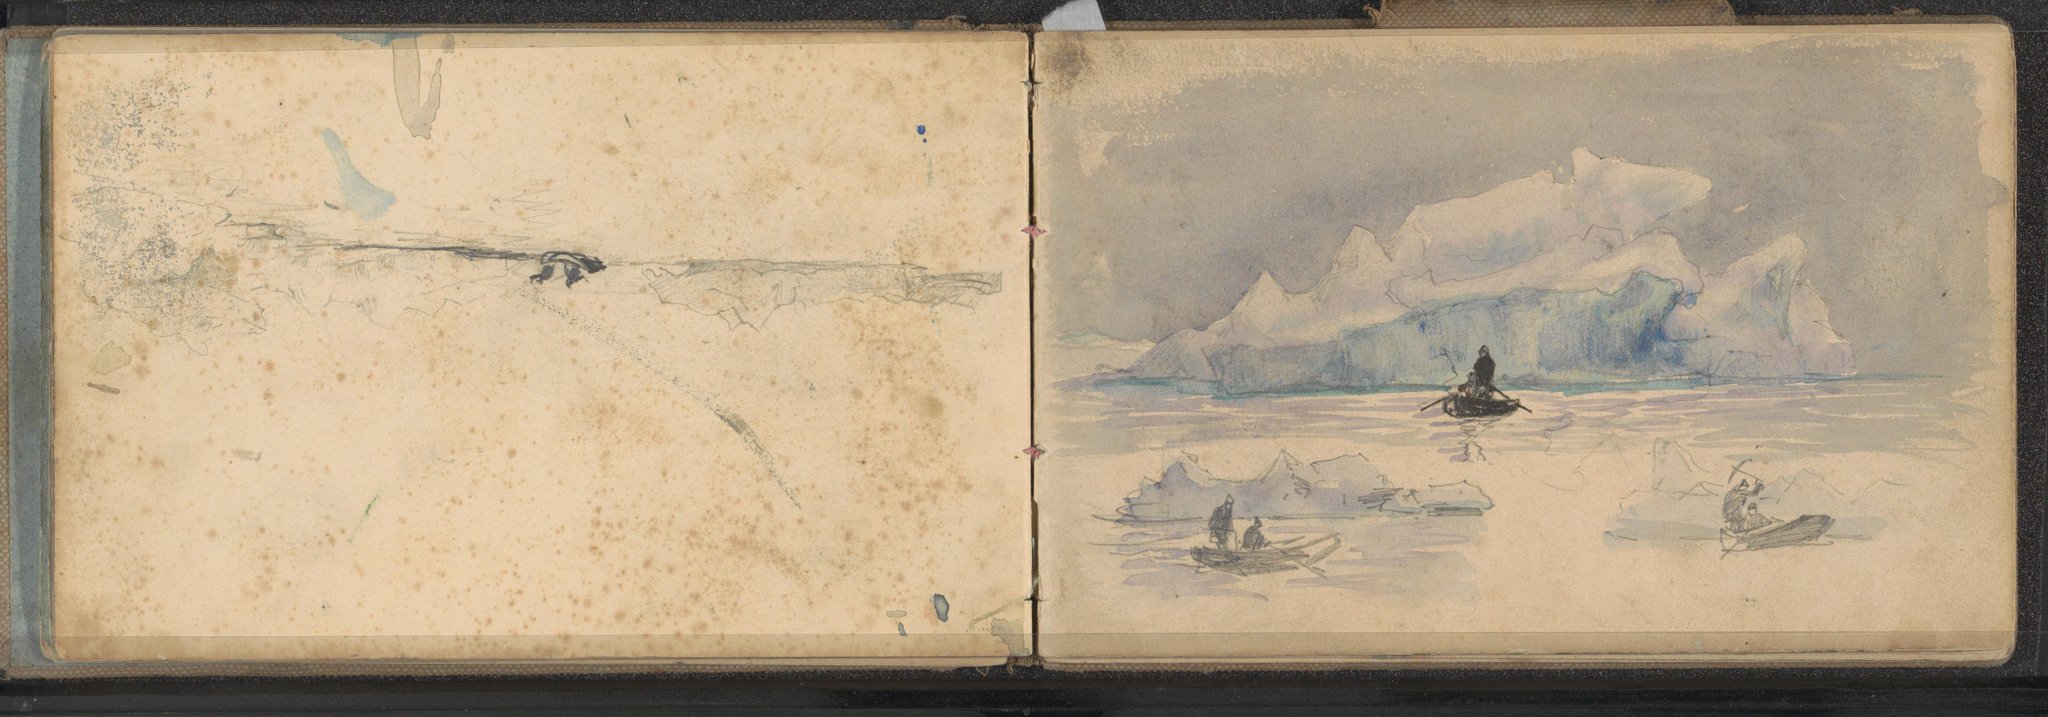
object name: sketchbook leaf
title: Aanbrengen van ijsankers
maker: louis apol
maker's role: draughtsman, painter, print maker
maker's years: 1850-1936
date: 1880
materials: paper, pencil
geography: barentsz sea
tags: iceberg, rowing-boat, canoe, etc. (+ two persons ~ traffic and transport), sea (seascape)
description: Twee mannen in een boot brengen ijsankers aan in een ijsberg. Blad 20 verso uit een schetsboek met 35 bladen betekend tijdens de expeditie naar Nova Zembla in 1880.